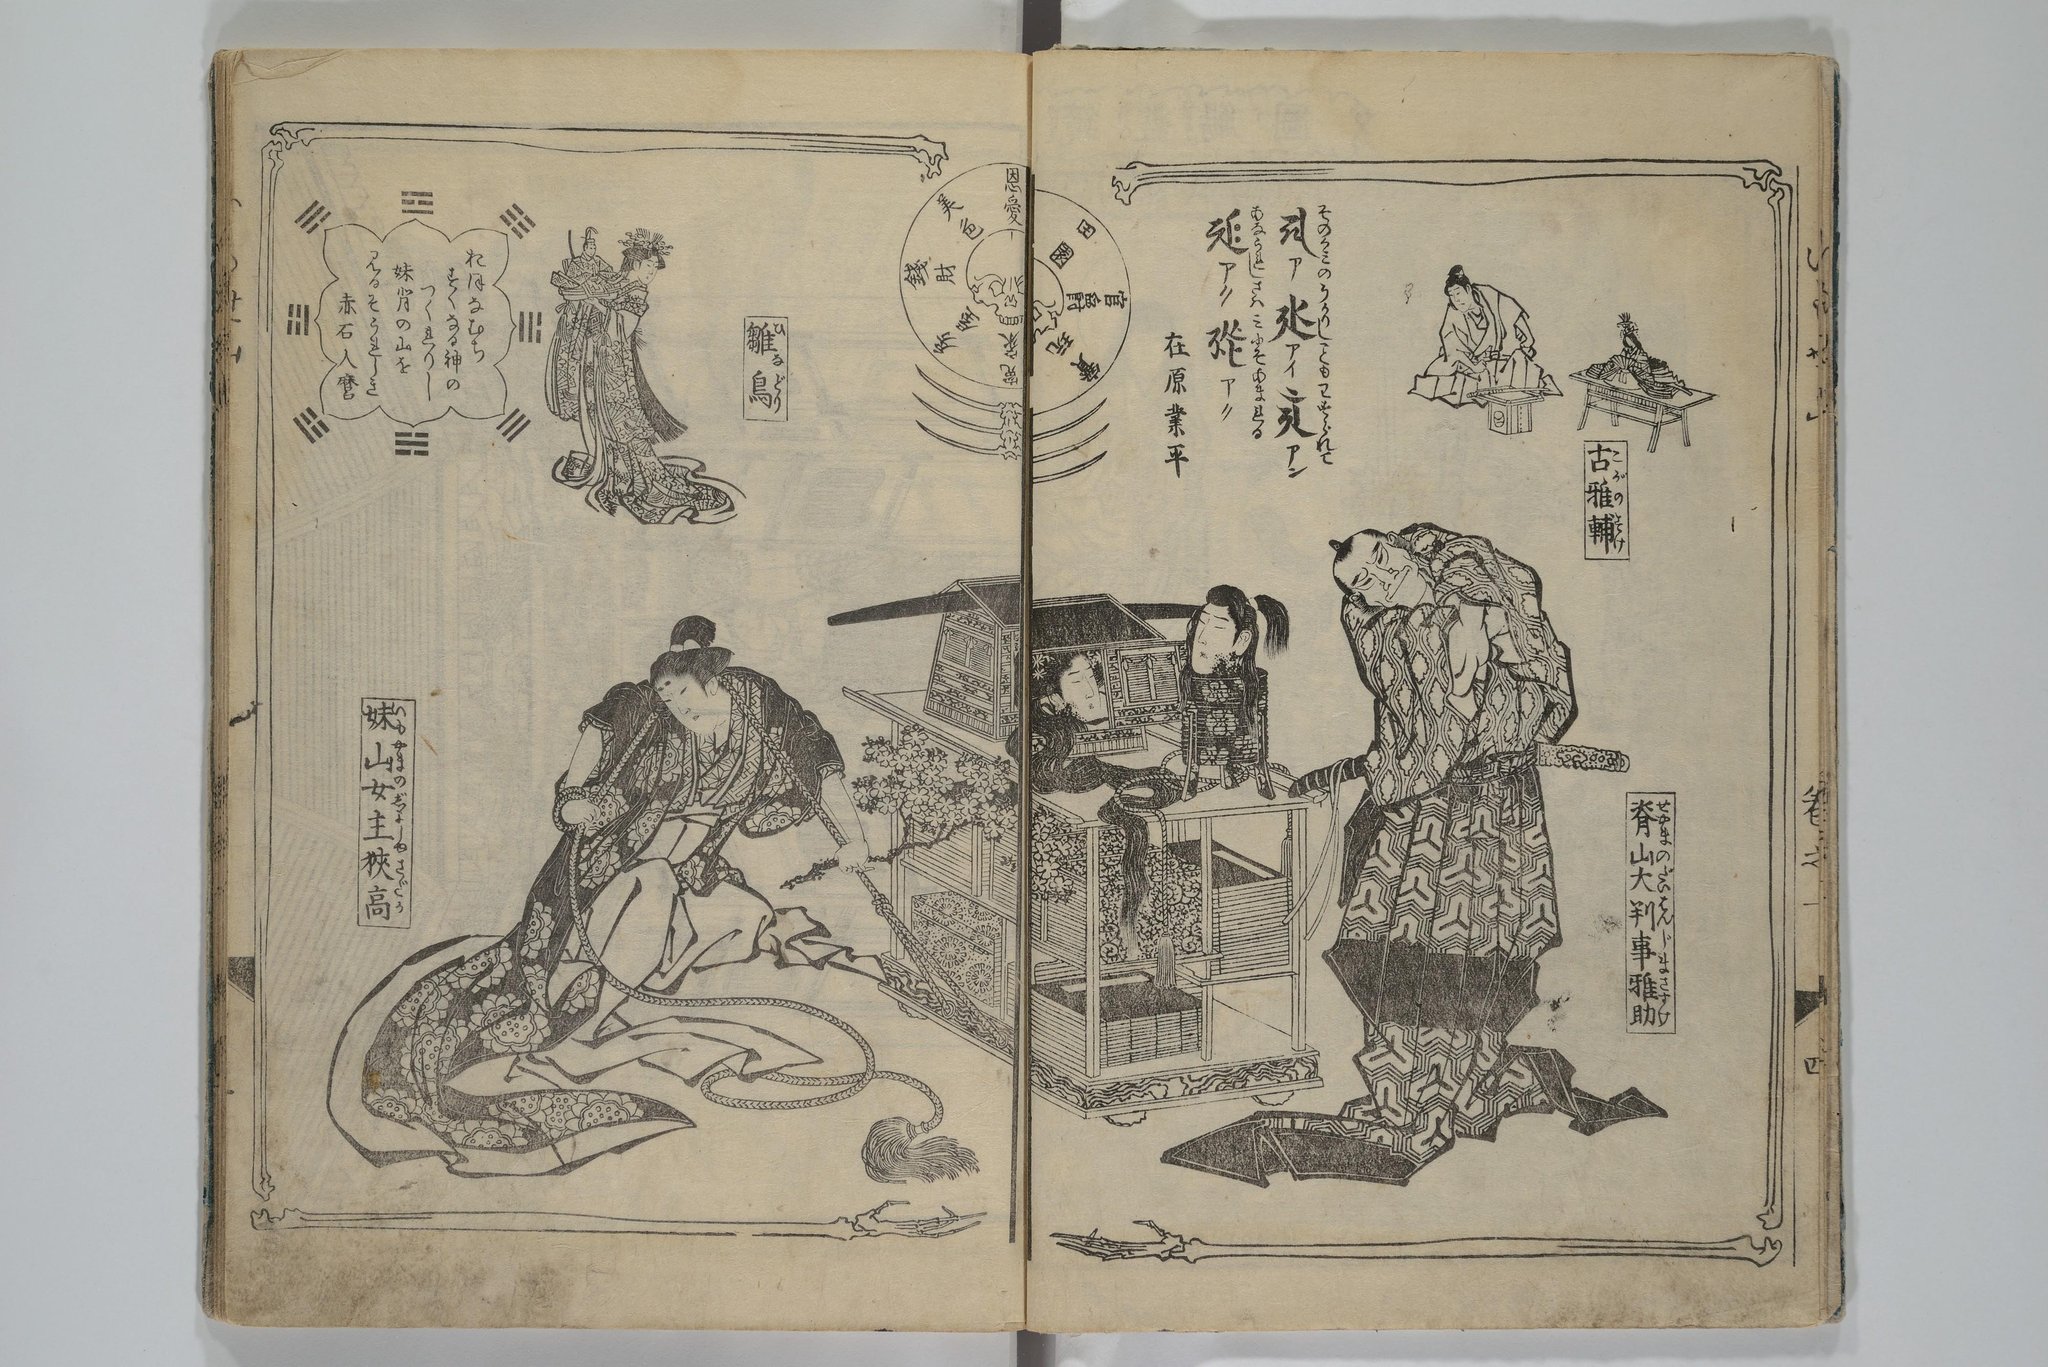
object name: illustrated book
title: The Mountains of Husband and Wife (Onyo imoseyama) 阥阦妹背山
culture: japanese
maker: katsushika hokusai 葛飾北斎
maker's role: artist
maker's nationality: japanese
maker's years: 1760-1849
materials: ink, paper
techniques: woodblock print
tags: heads,men,women